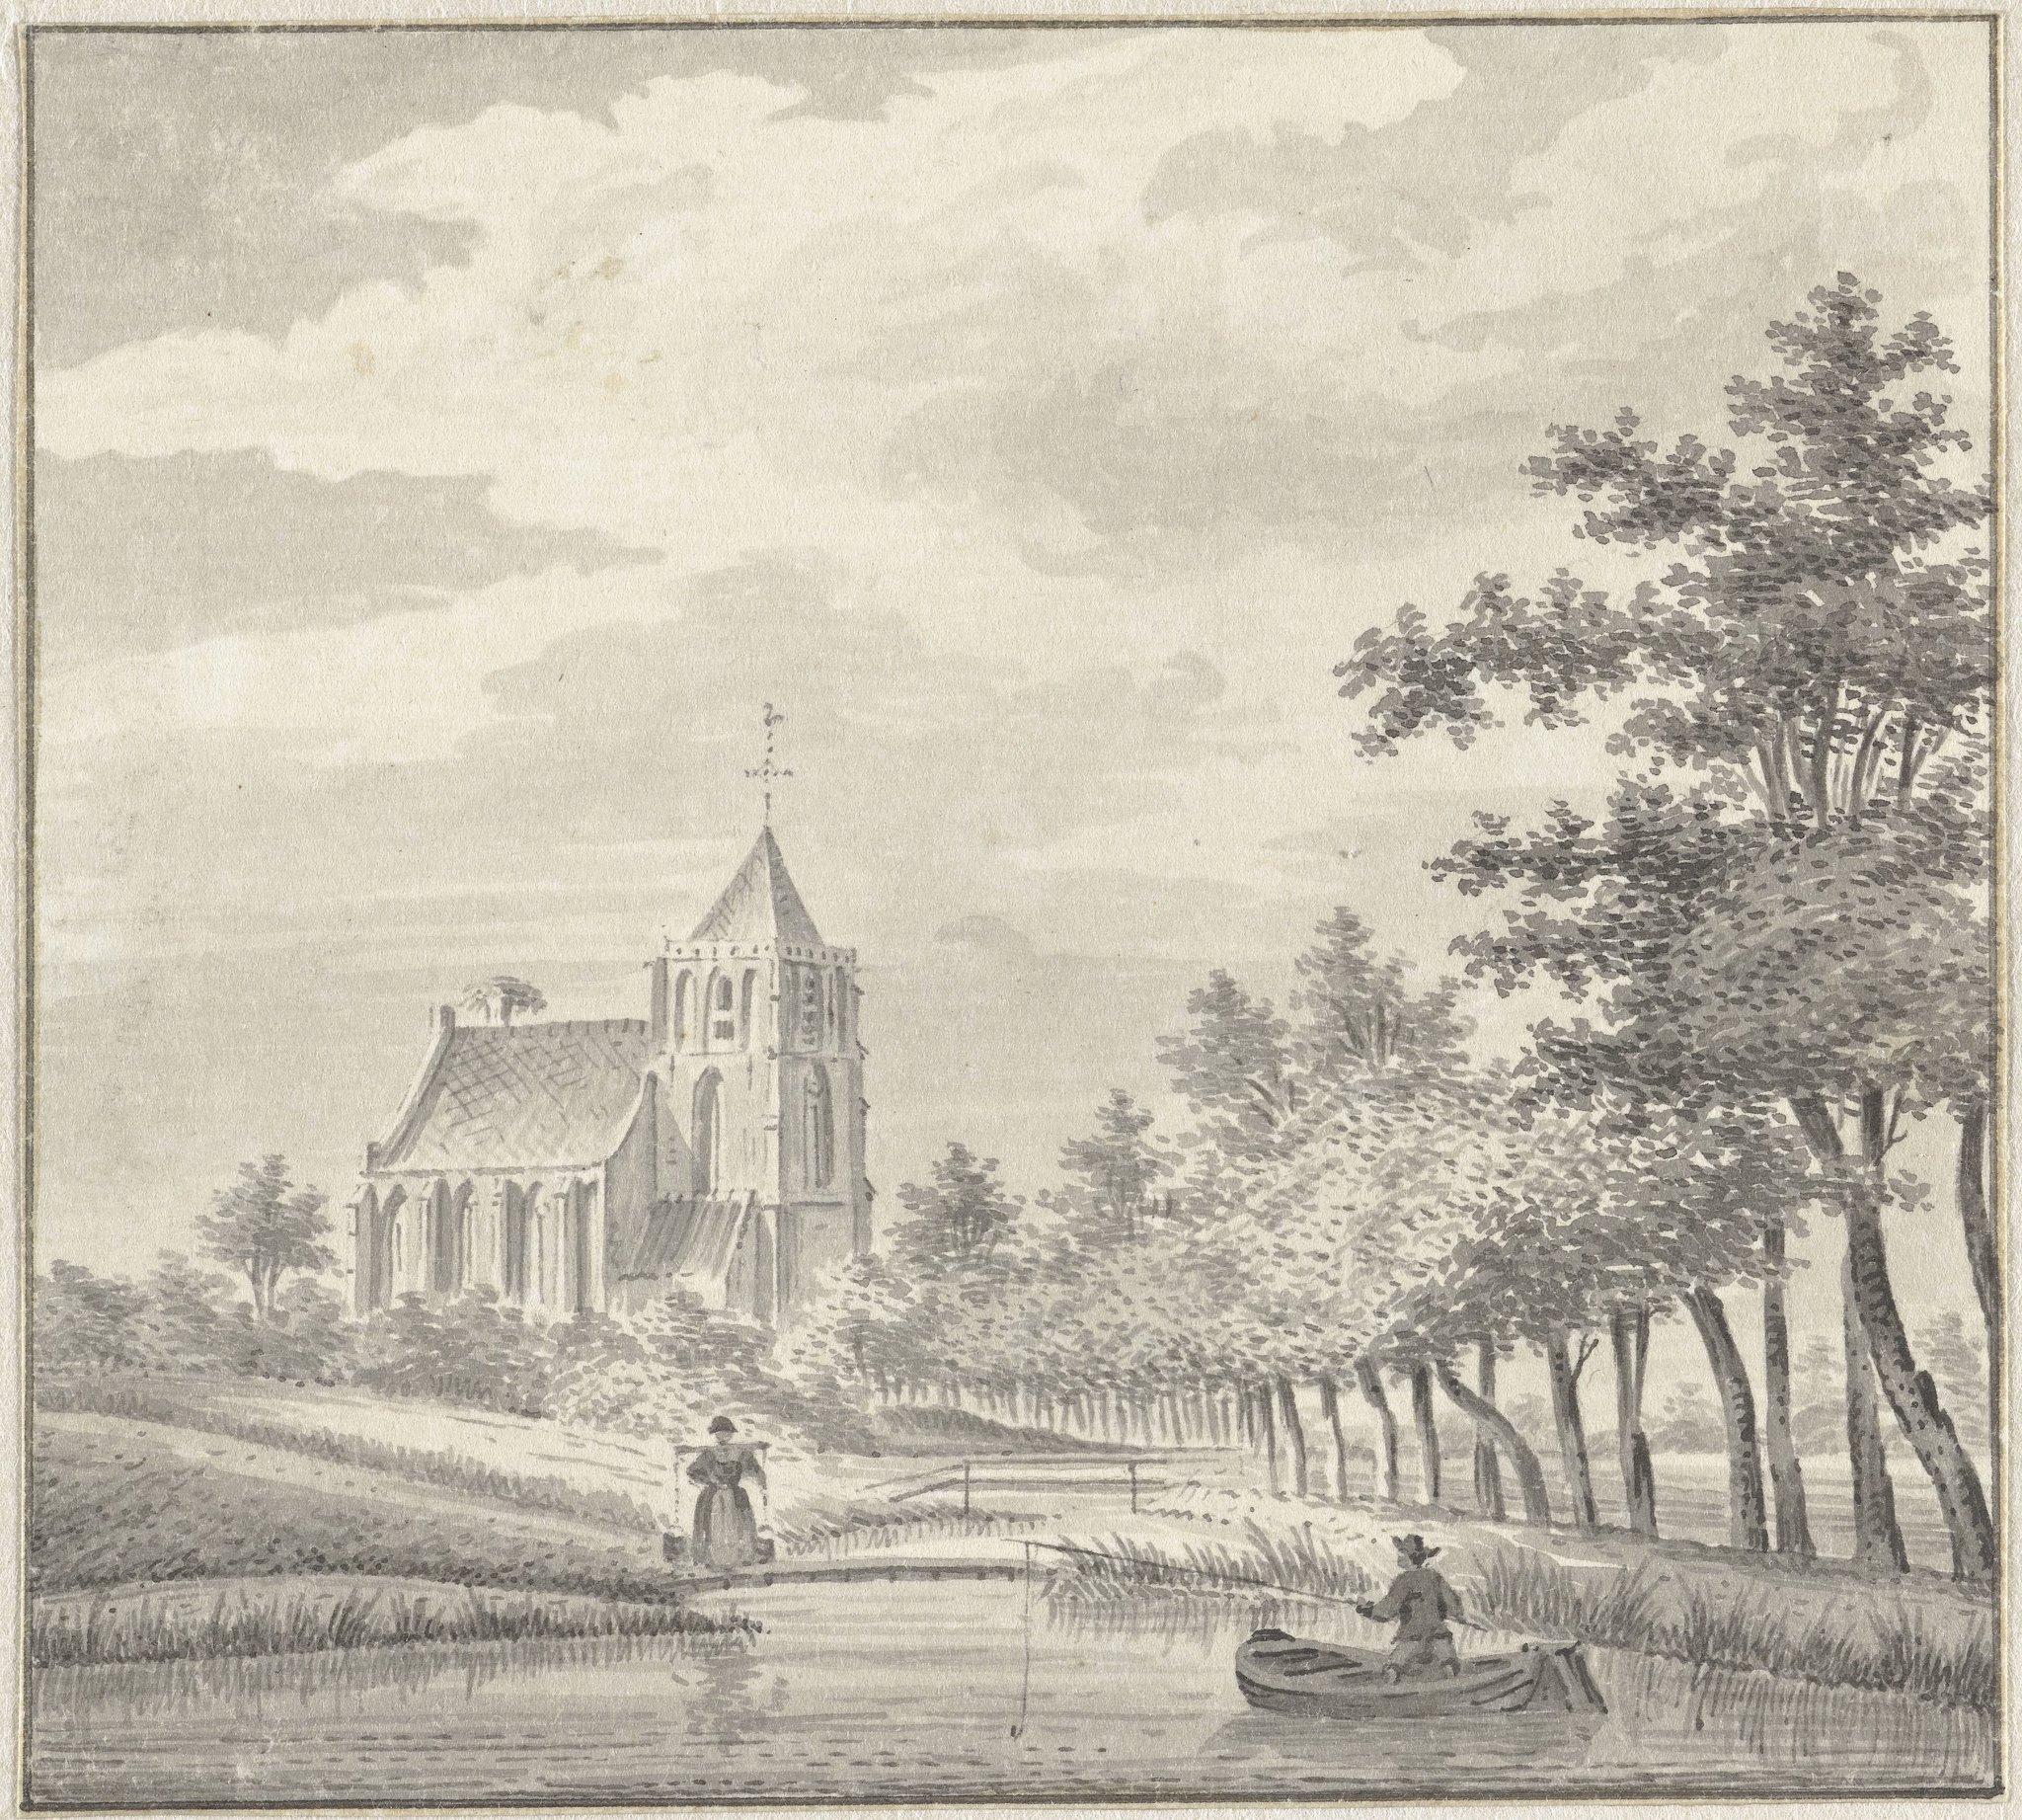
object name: drawing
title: Gezicht op de kerk van Leerbroek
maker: jan de beijer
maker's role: draughtsman, print maker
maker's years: 1703-1780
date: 1713-1780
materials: ink, paper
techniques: brush, pen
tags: church (exterior)